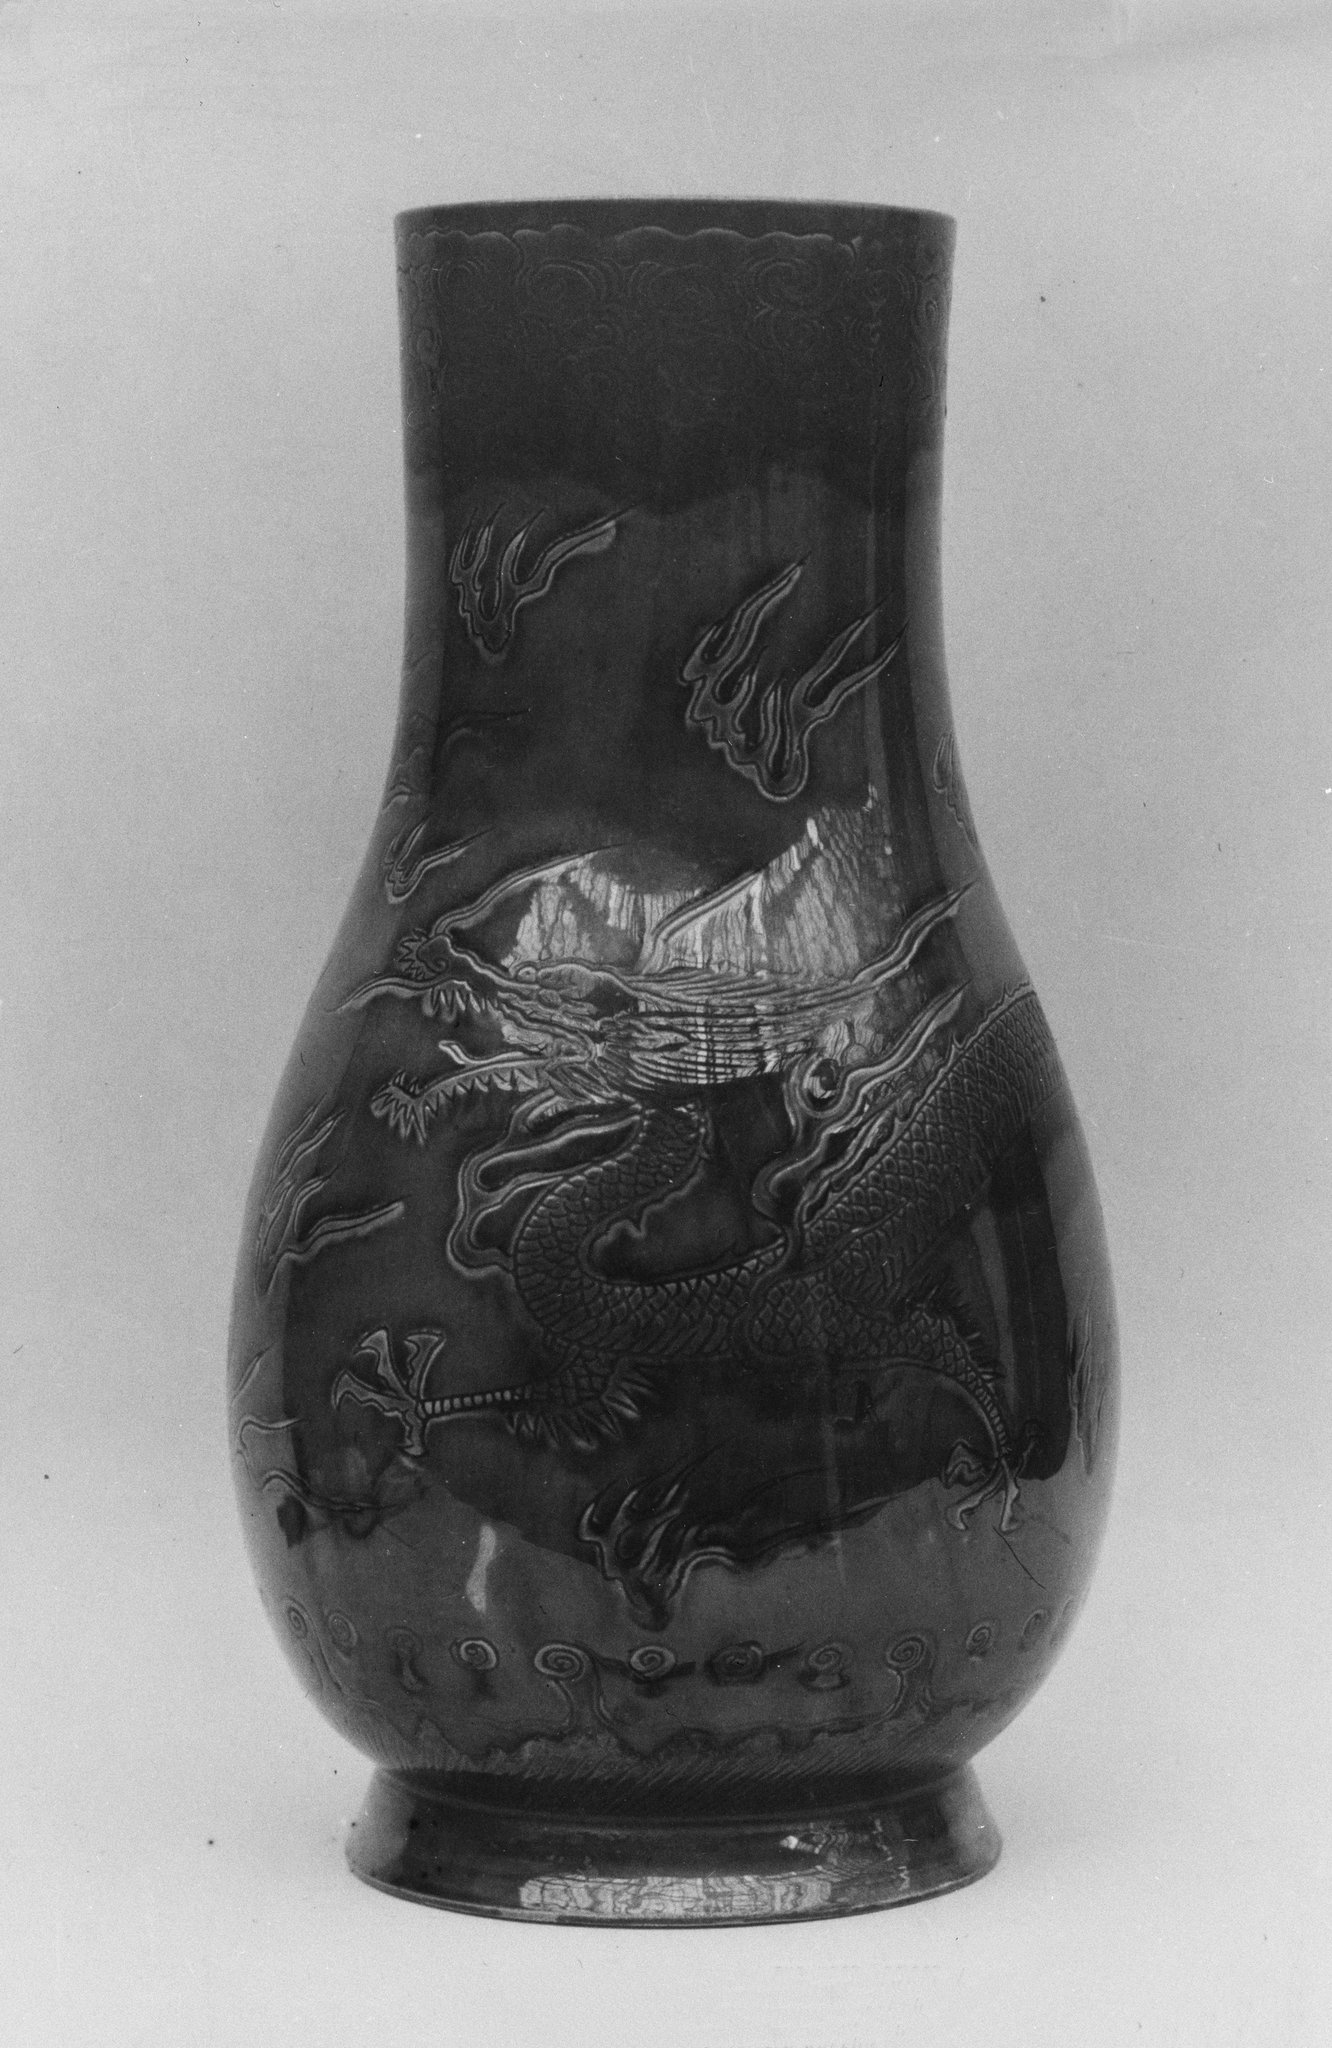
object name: vase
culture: japanese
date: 1801-1900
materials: glaze, porcelain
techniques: relief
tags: dragons